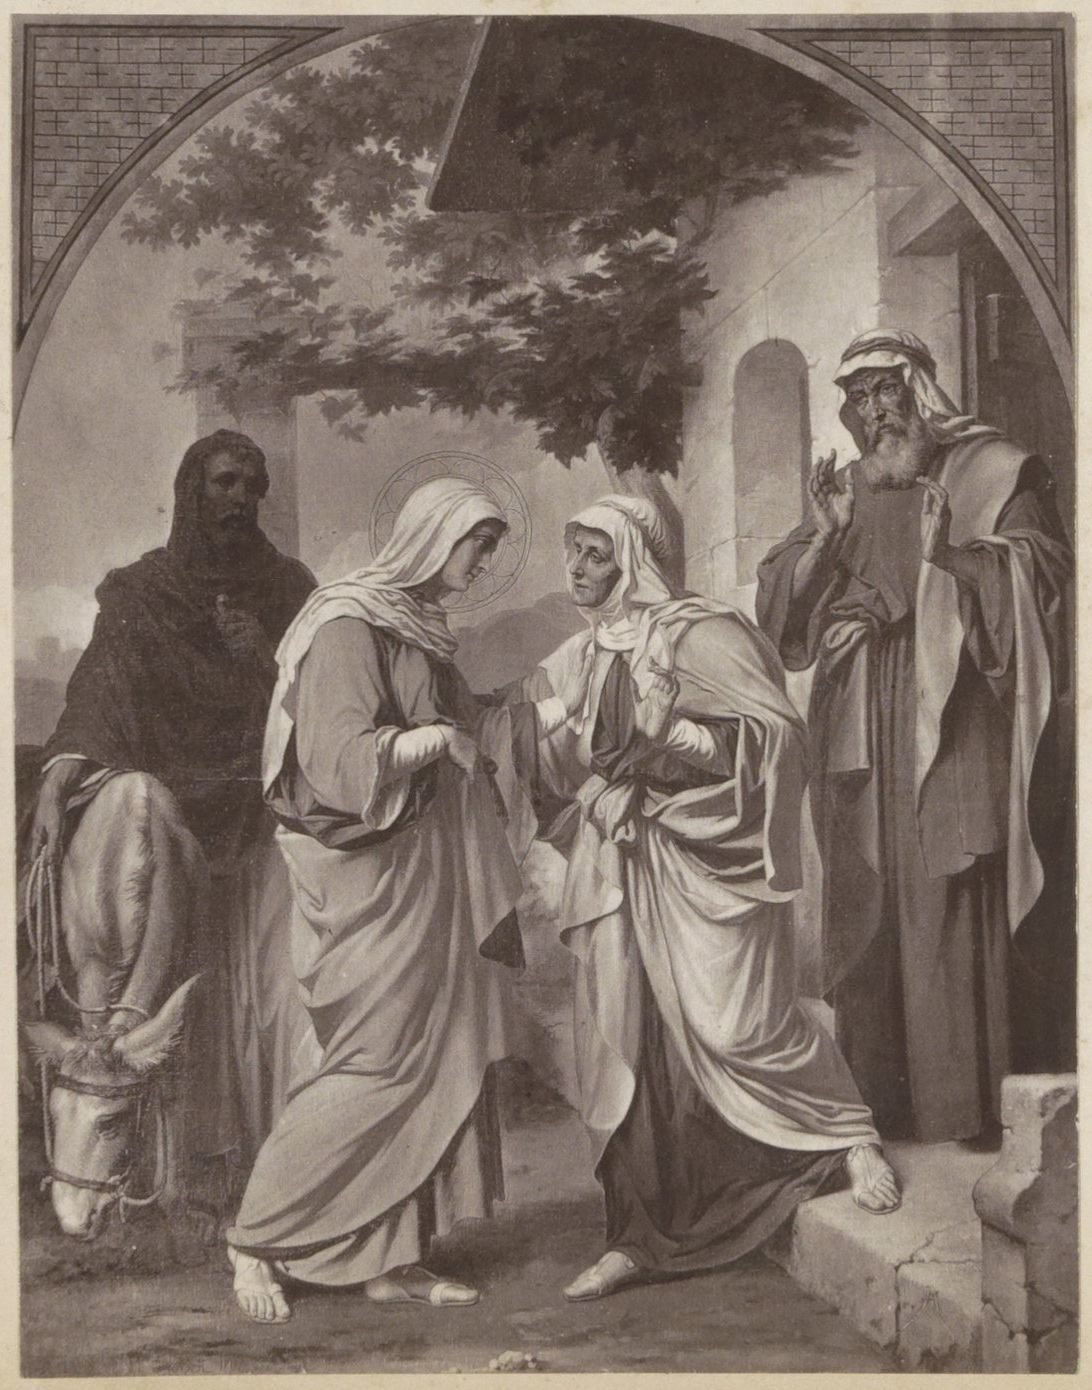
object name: photograph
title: Fotoreproductie van (vermoedelijk) een tekening van de Visitatie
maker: Anonymous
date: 1850-1870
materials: paper, photographic support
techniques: albumen print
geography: england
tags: mary and elisabeth, both pregnant, embracing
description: Onderdeel van Album met foto's van bezienswaardigheden en landschappen in Engeland en van kunst.